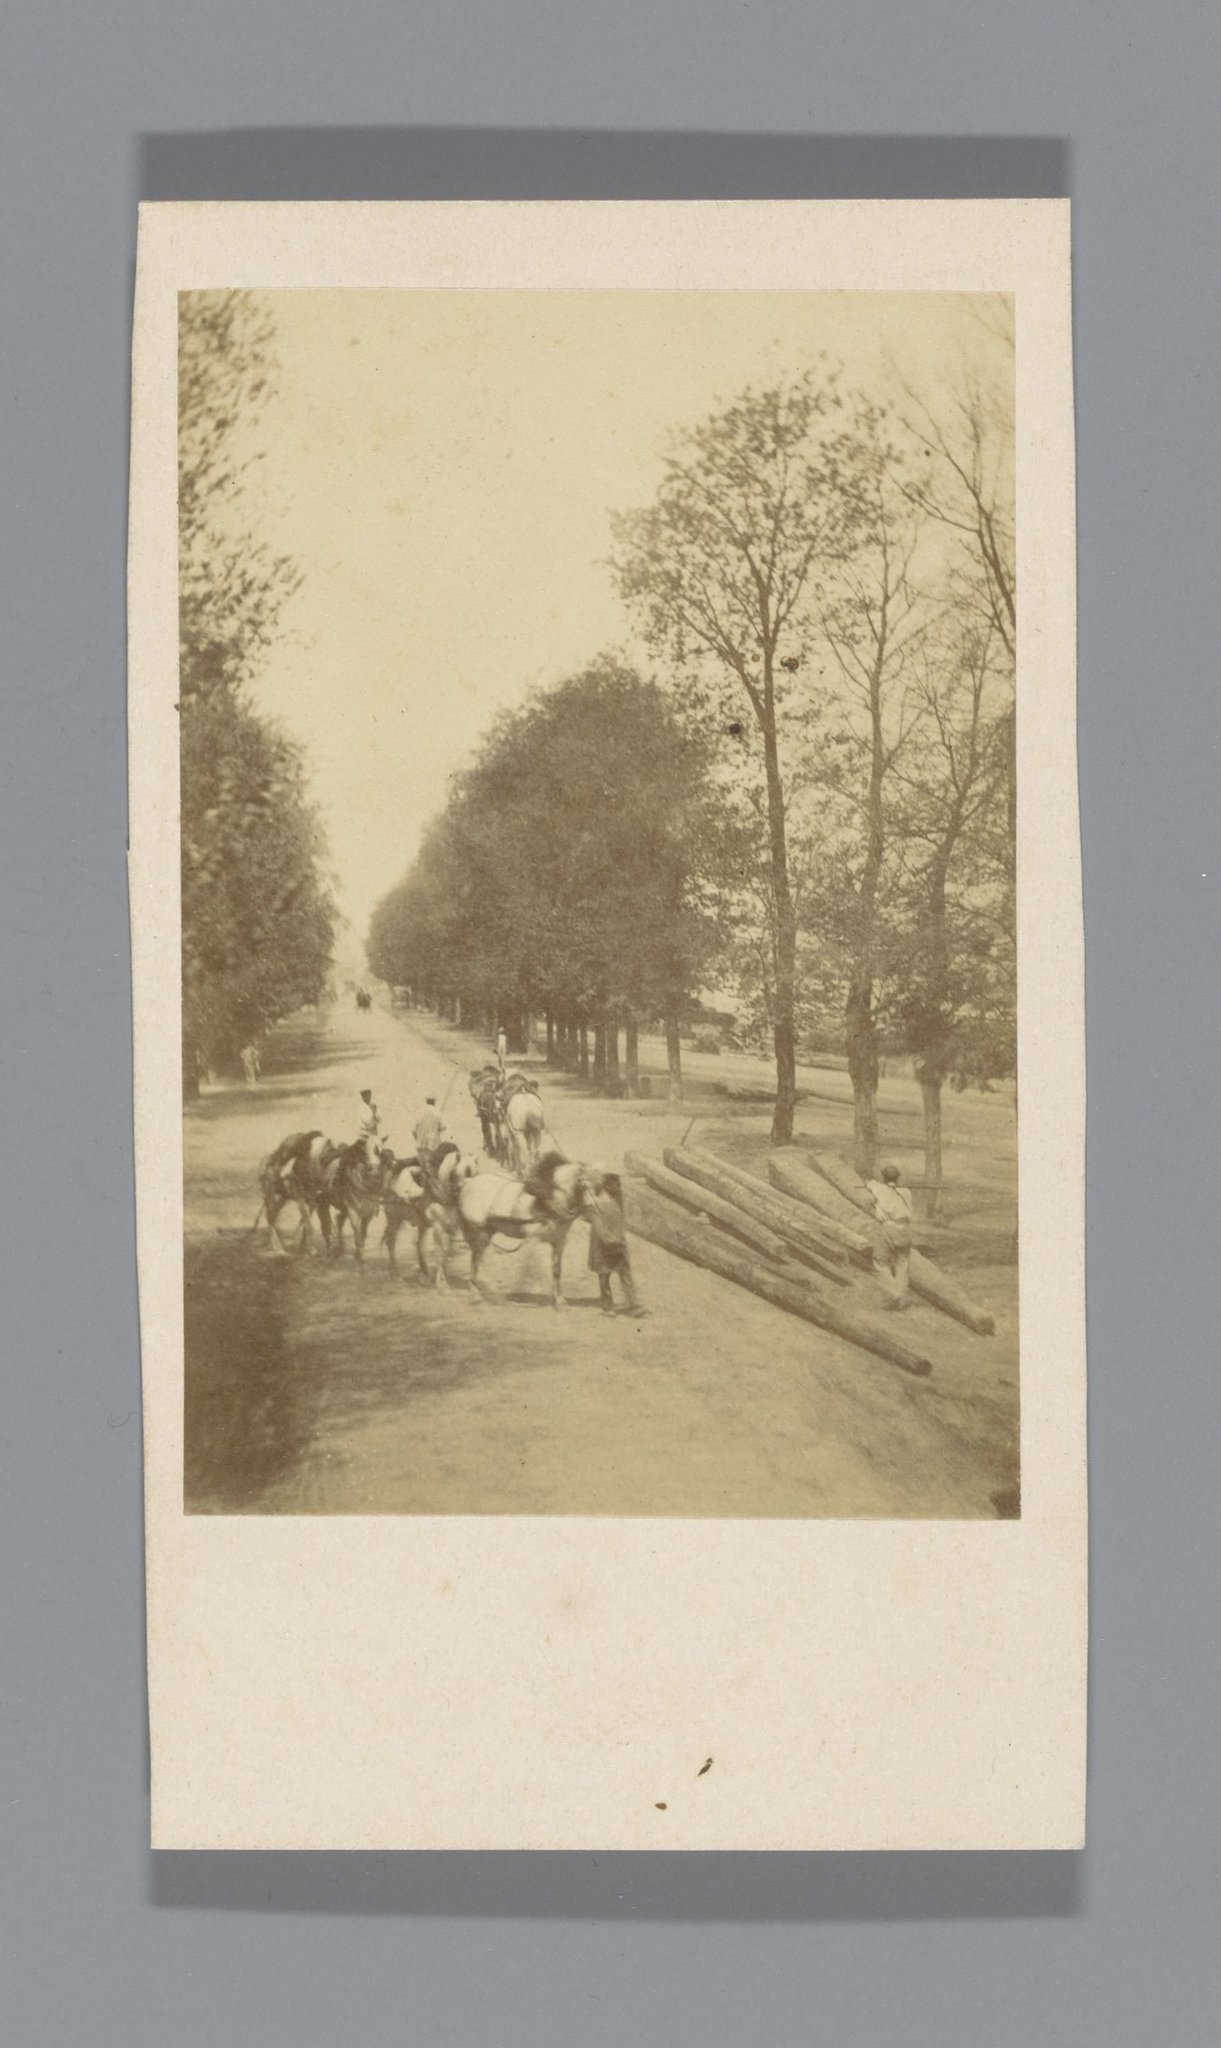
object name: carte de visite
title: Ruiters op de Quai de la Conférence, Parijs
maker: Anonymous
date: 1865-1870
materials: cardboard, paper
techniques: albumen print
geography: paris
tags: riding a horse, ass, or mule; rider, horseman, paris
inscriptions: inscription: ‘Quai de la Confèrence/ Paris’